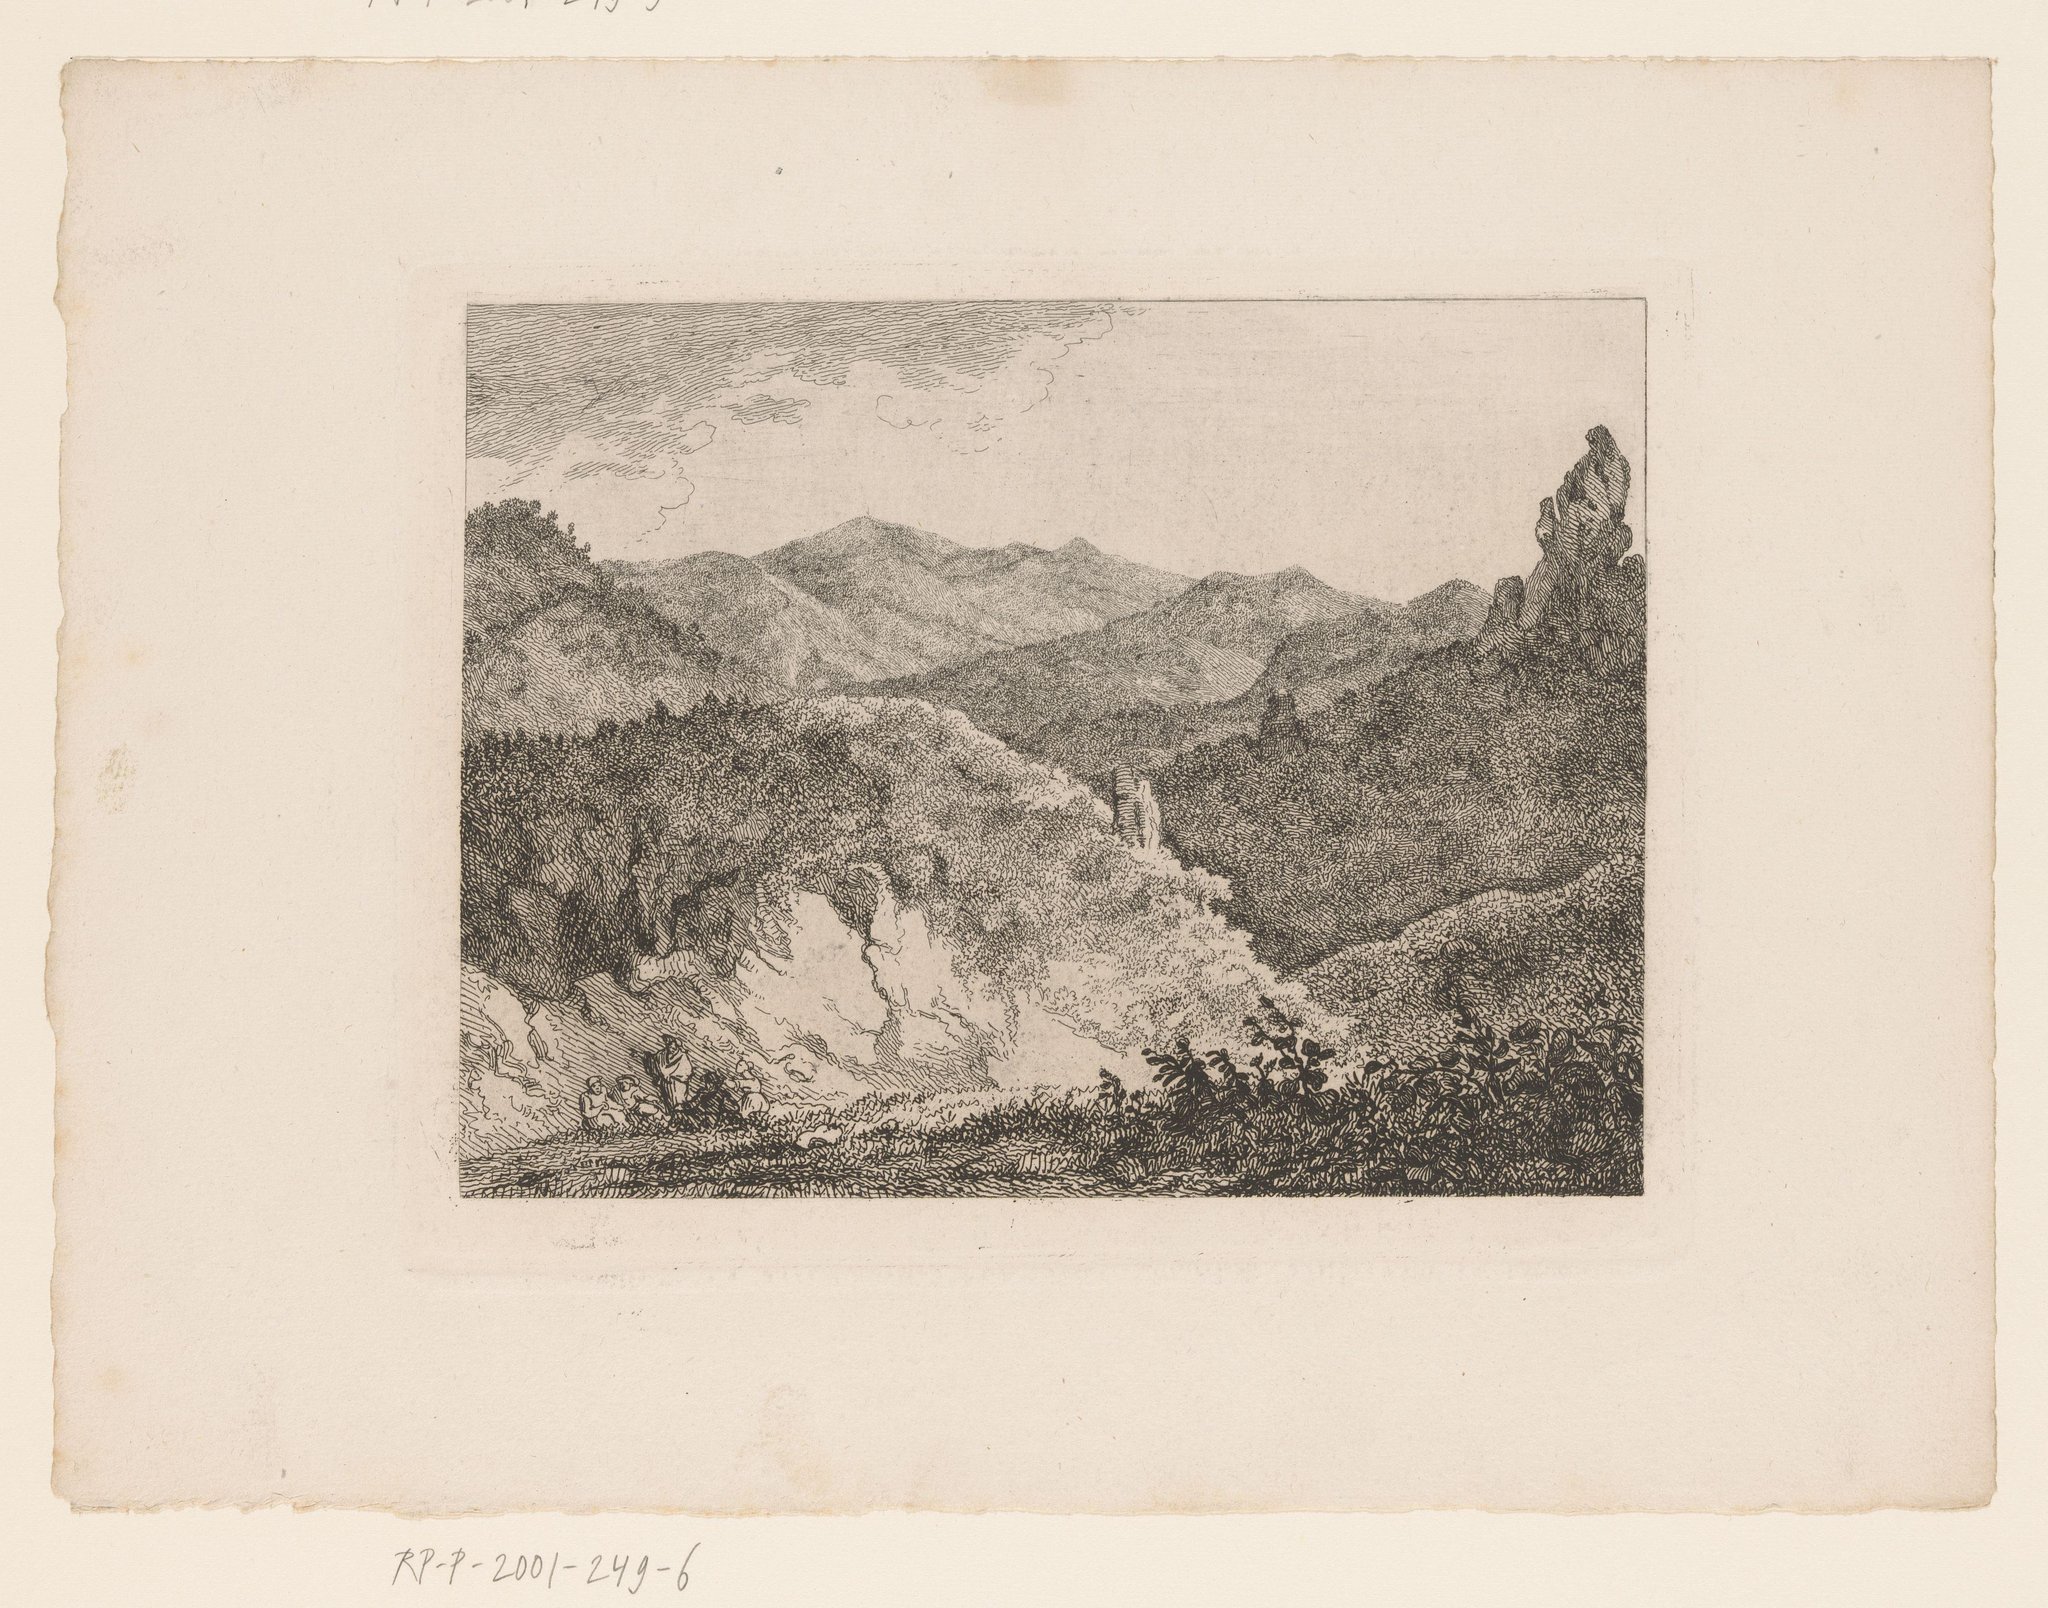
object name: print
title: Berglandschap bij avond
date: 1779-1807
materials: paper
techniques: etching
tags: evening, mountains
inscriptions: collector's mark: Lugt 2228, collector's mark: Lugt 2760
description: Onderdeel van een serie van vijf prenten en een titelprent.